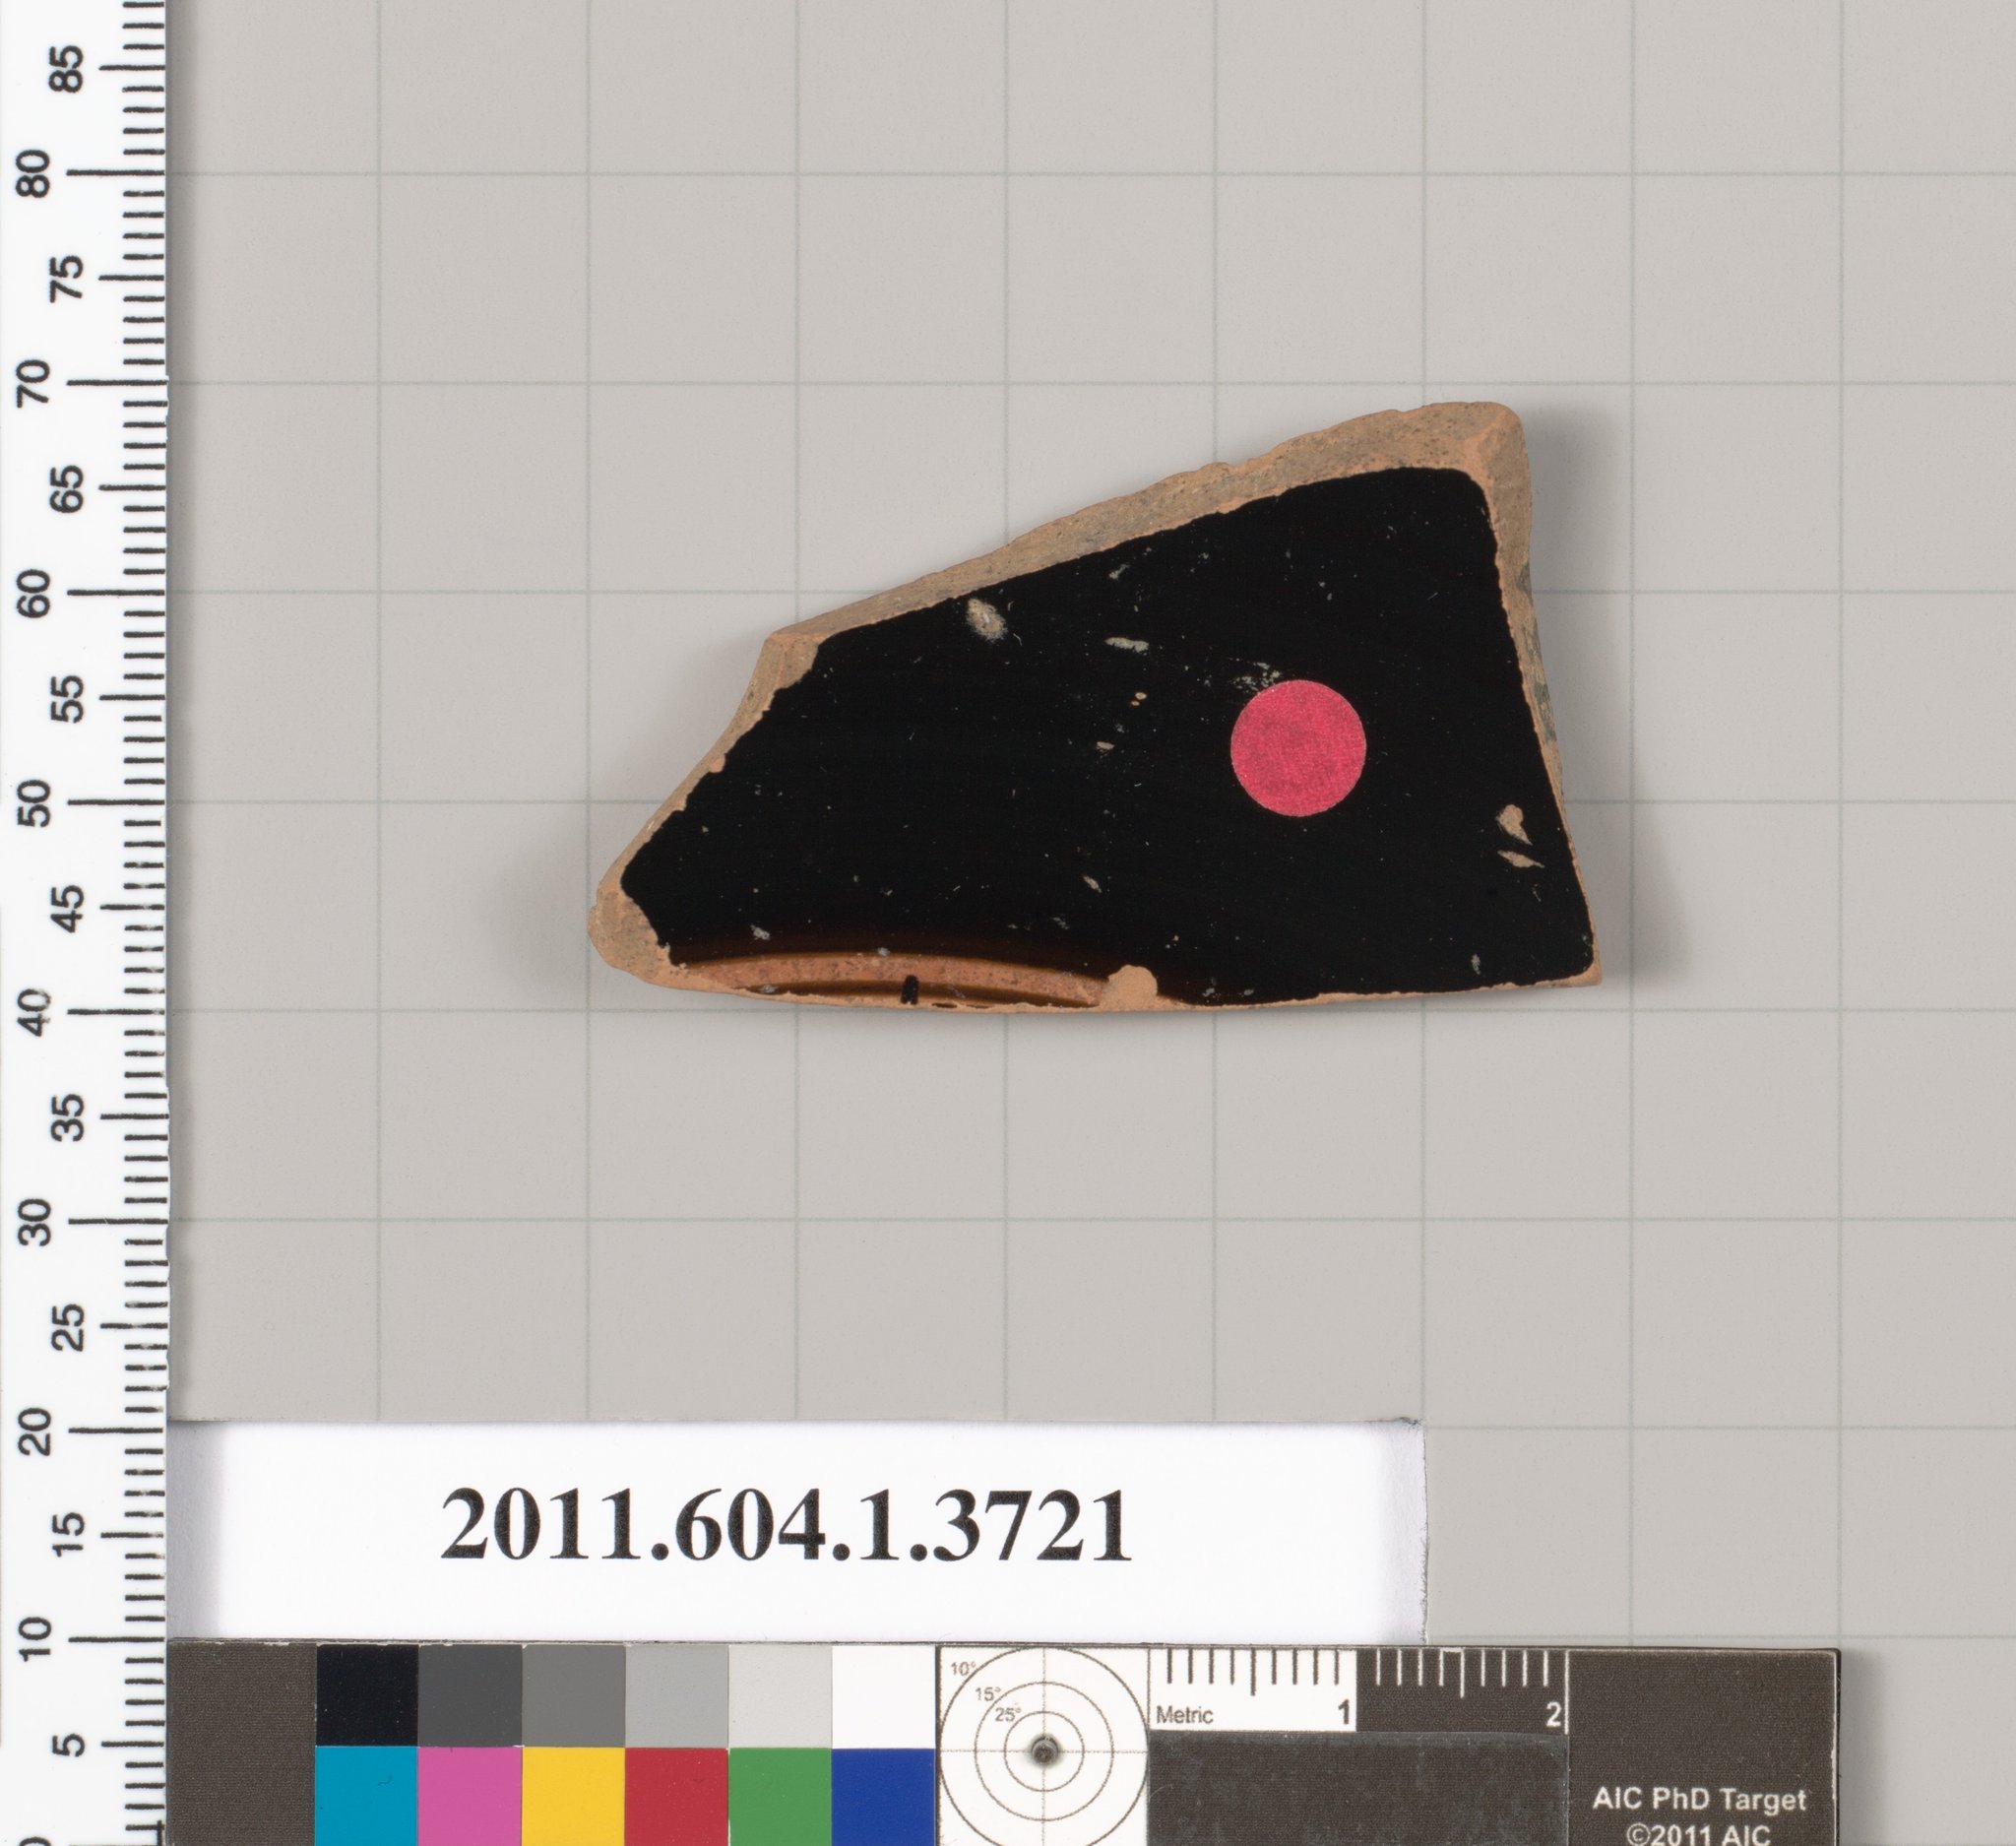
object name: kylix fragment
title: Terracotta fragment of a kylix (drinking cup)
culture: greek, attic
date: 475-451 BCE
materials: terracotta